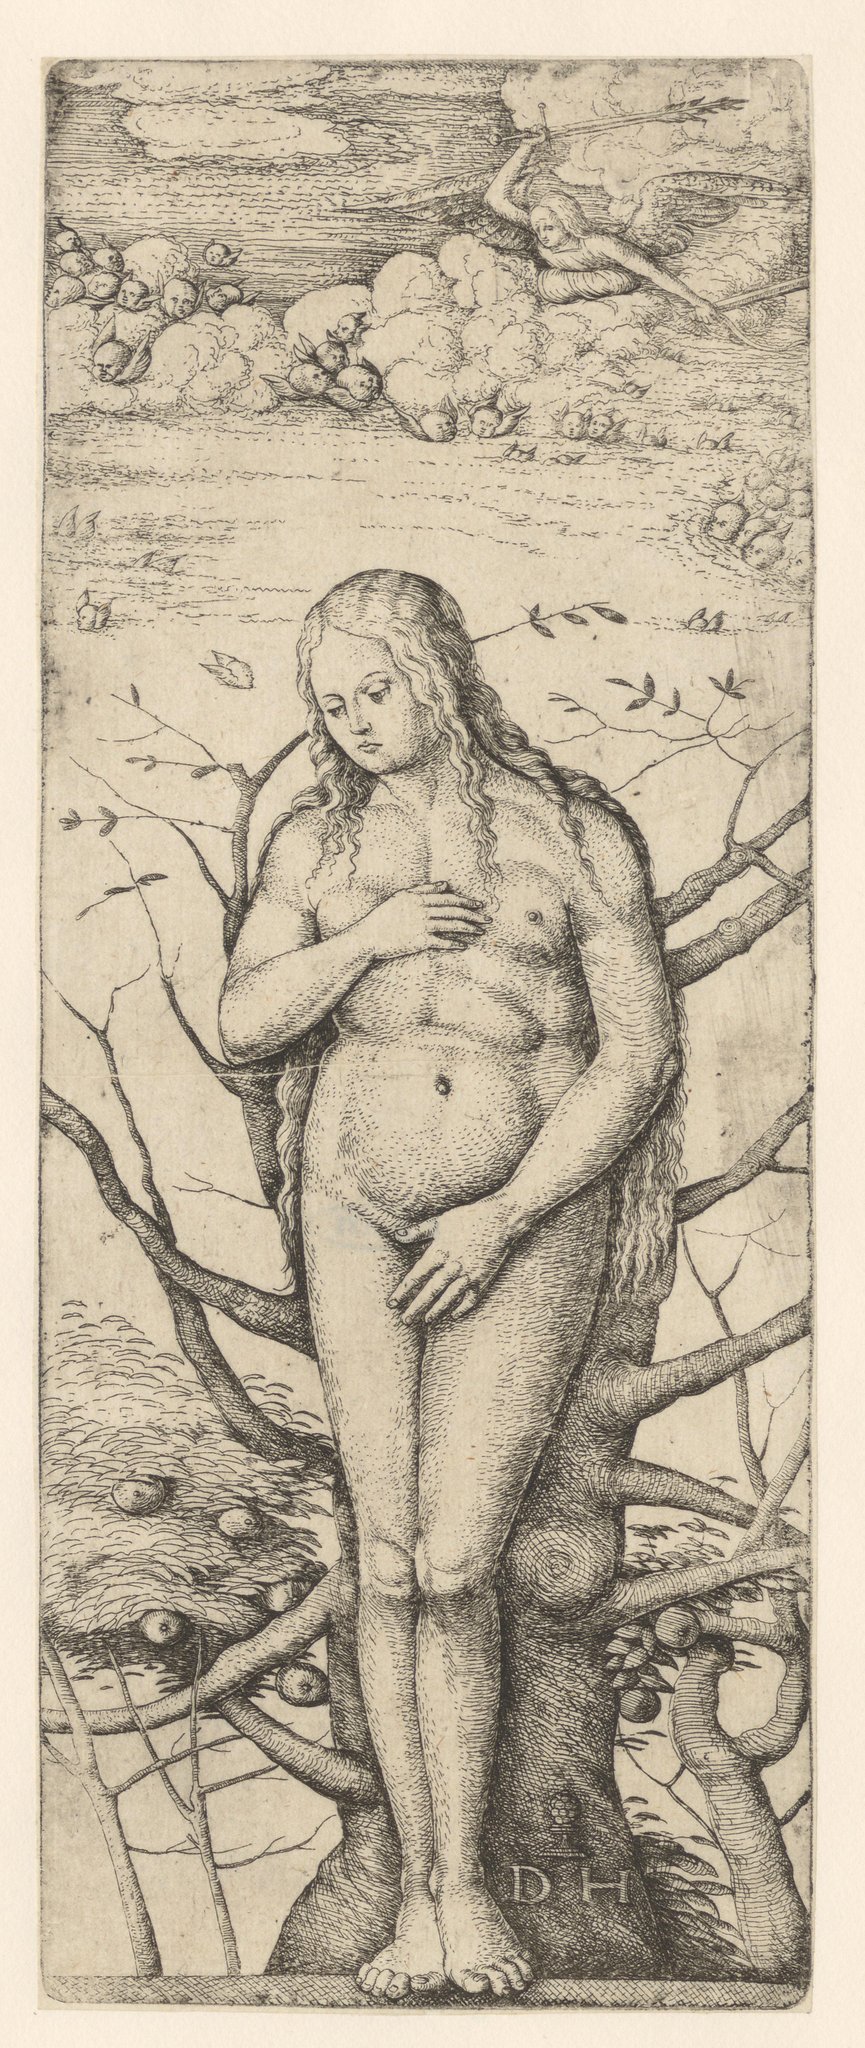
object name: print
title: Eva na de zondeval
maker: daniel hopfer (i)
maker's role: print maker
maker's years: 1470-1536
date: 1505-1536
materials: paper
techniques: etching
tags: cherubs, i.e. children's heads with wings, adam and/or eve overcome with repentance, adam and eve discover their nakedness; they cover themselves with their hands or with leaves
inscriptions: collector's mark: Lugt 2228